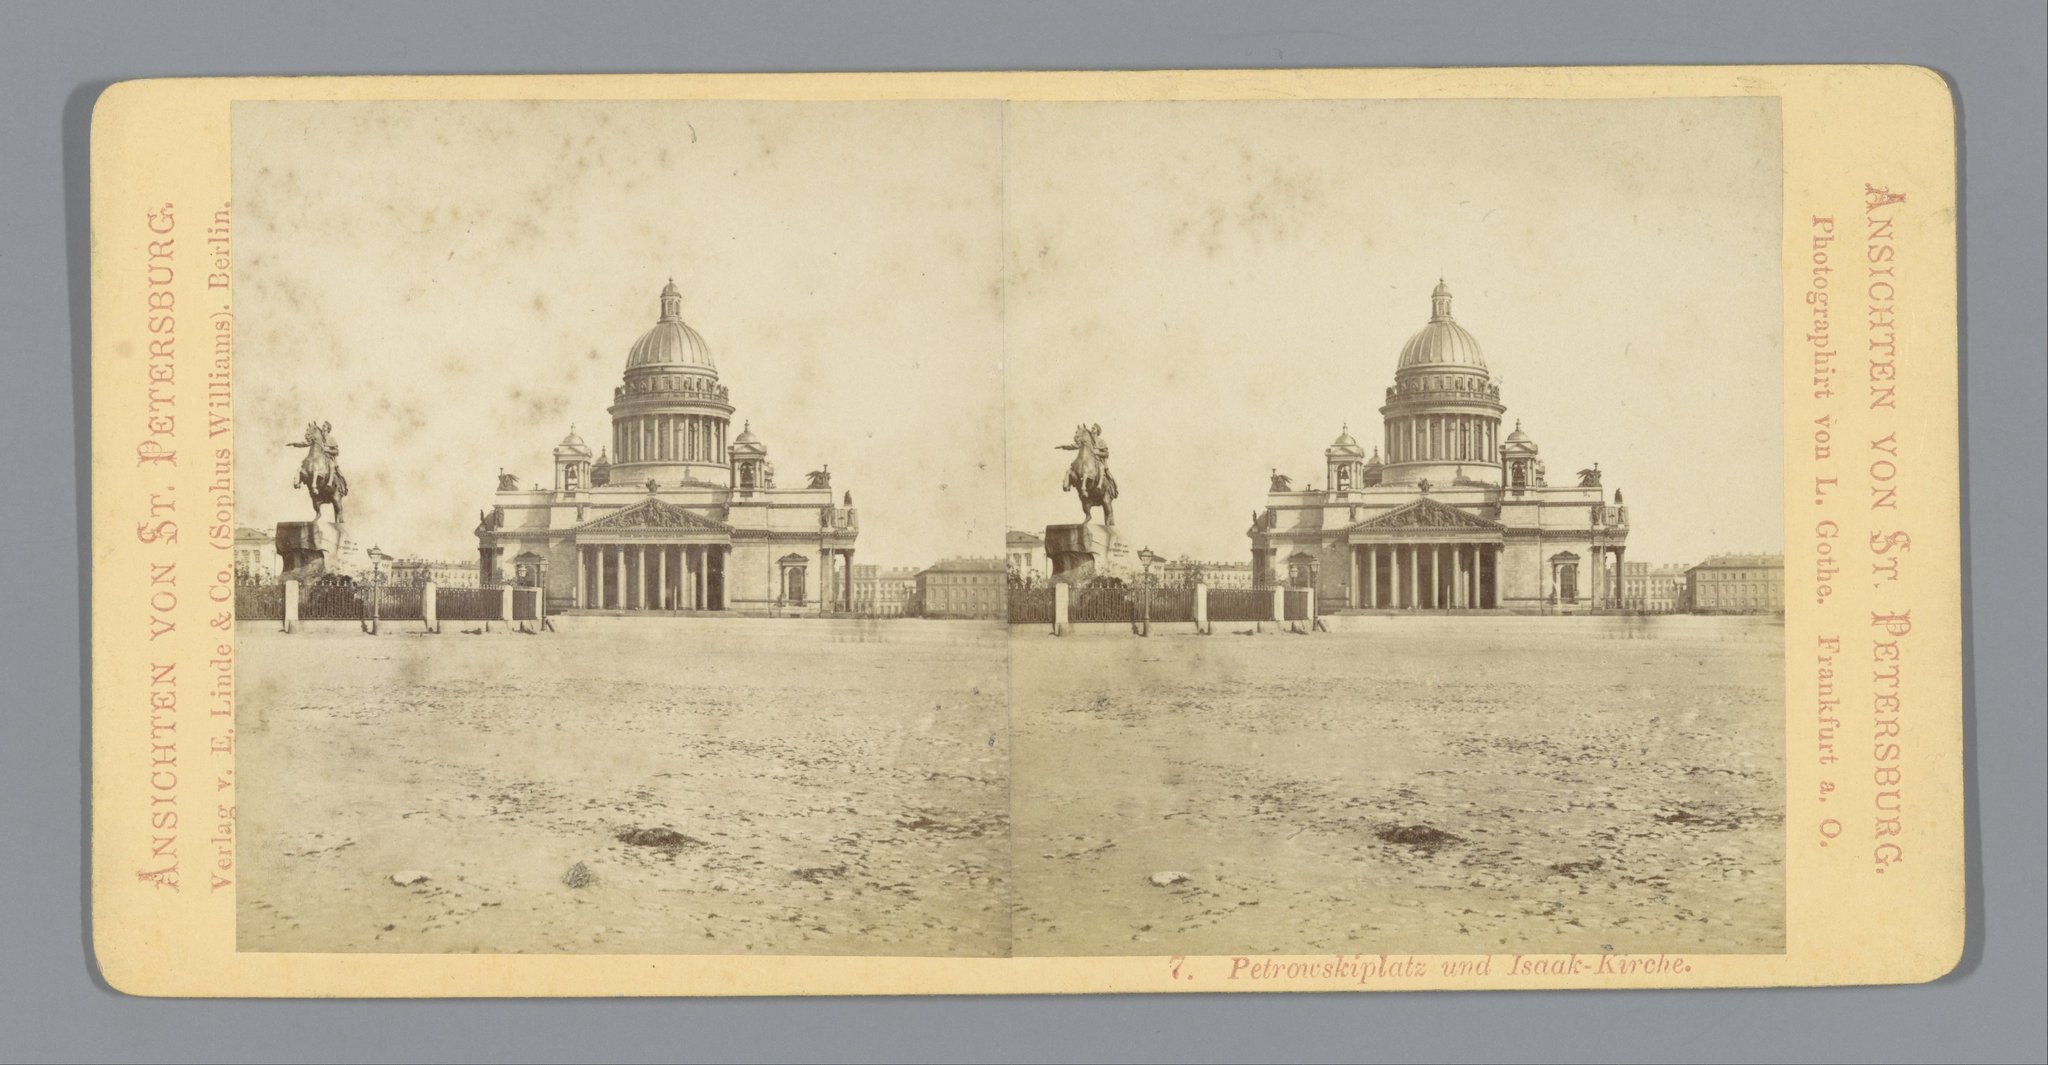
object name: stereograph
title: Petrowskiplatz und Isaak-Kirche.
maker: louis gothe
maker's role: fotograaf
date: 1850-1880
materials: cardboard, photographic support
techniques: albumen print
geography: berlin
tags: square, place, circus, etc., church (exterior), equestrian statue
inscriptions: inscription: ‘Ansichten von St. Petersburg.’, number: ‘7.’